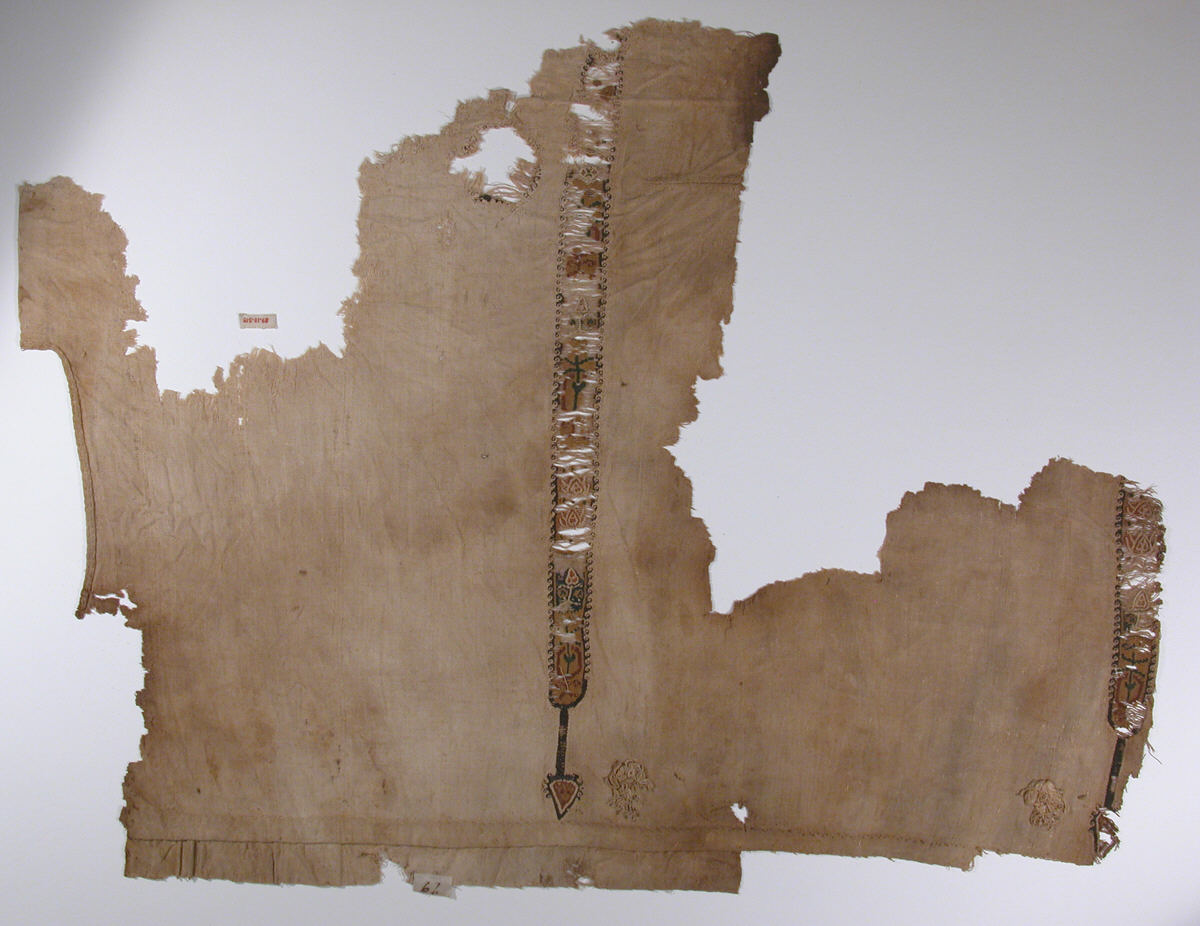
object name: textile fragment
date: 401-600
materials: linen, wool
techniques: weave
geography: egypt